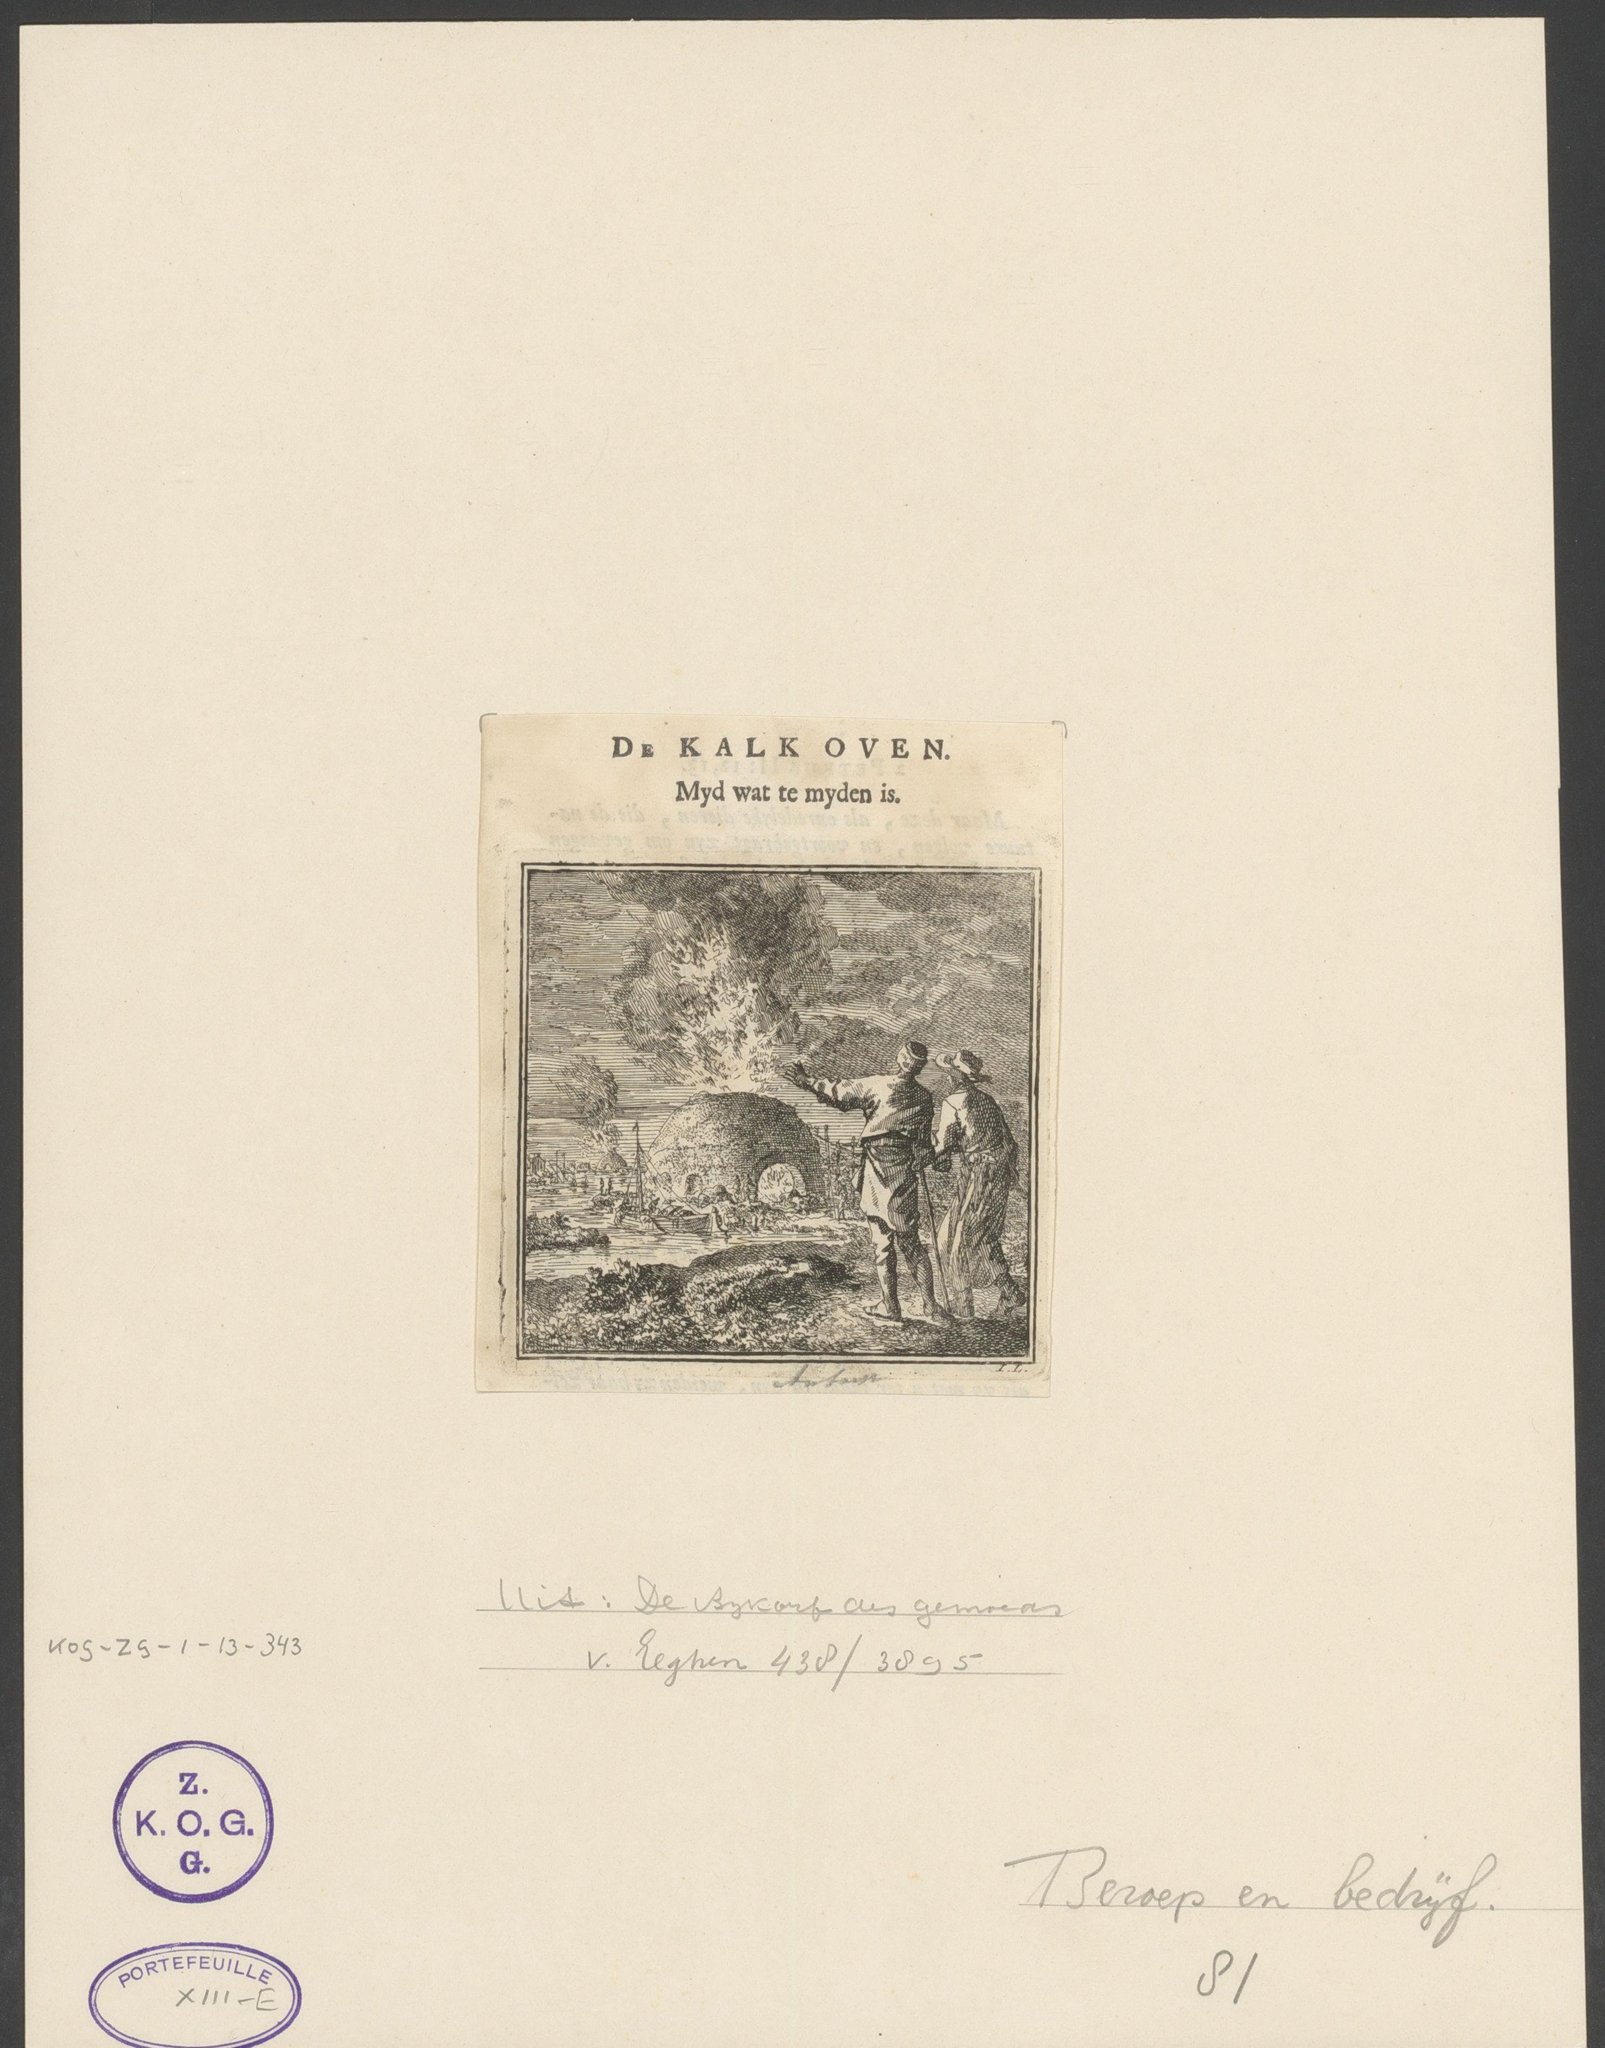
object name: print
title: Twee mannen wijzen op een brandende kalkoven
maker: jan luyken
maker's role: draughtsman, print maker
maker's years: 1649-1712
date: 1711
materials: paper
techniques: etching, letterpress printing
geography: amsterdam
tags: kinds of non-precious stone: chalk, fire, oven, furnace ~ interior of industrial structure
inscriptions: collector's mark: Lugt 1641, stamp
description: Onderwerpsrubrieken binnen de Atlas Zeden en Gewoonten: Handel, Nijverheid en verkeer, Beroep en bedrijf, Mannelijk, Bewerkers van den steen.